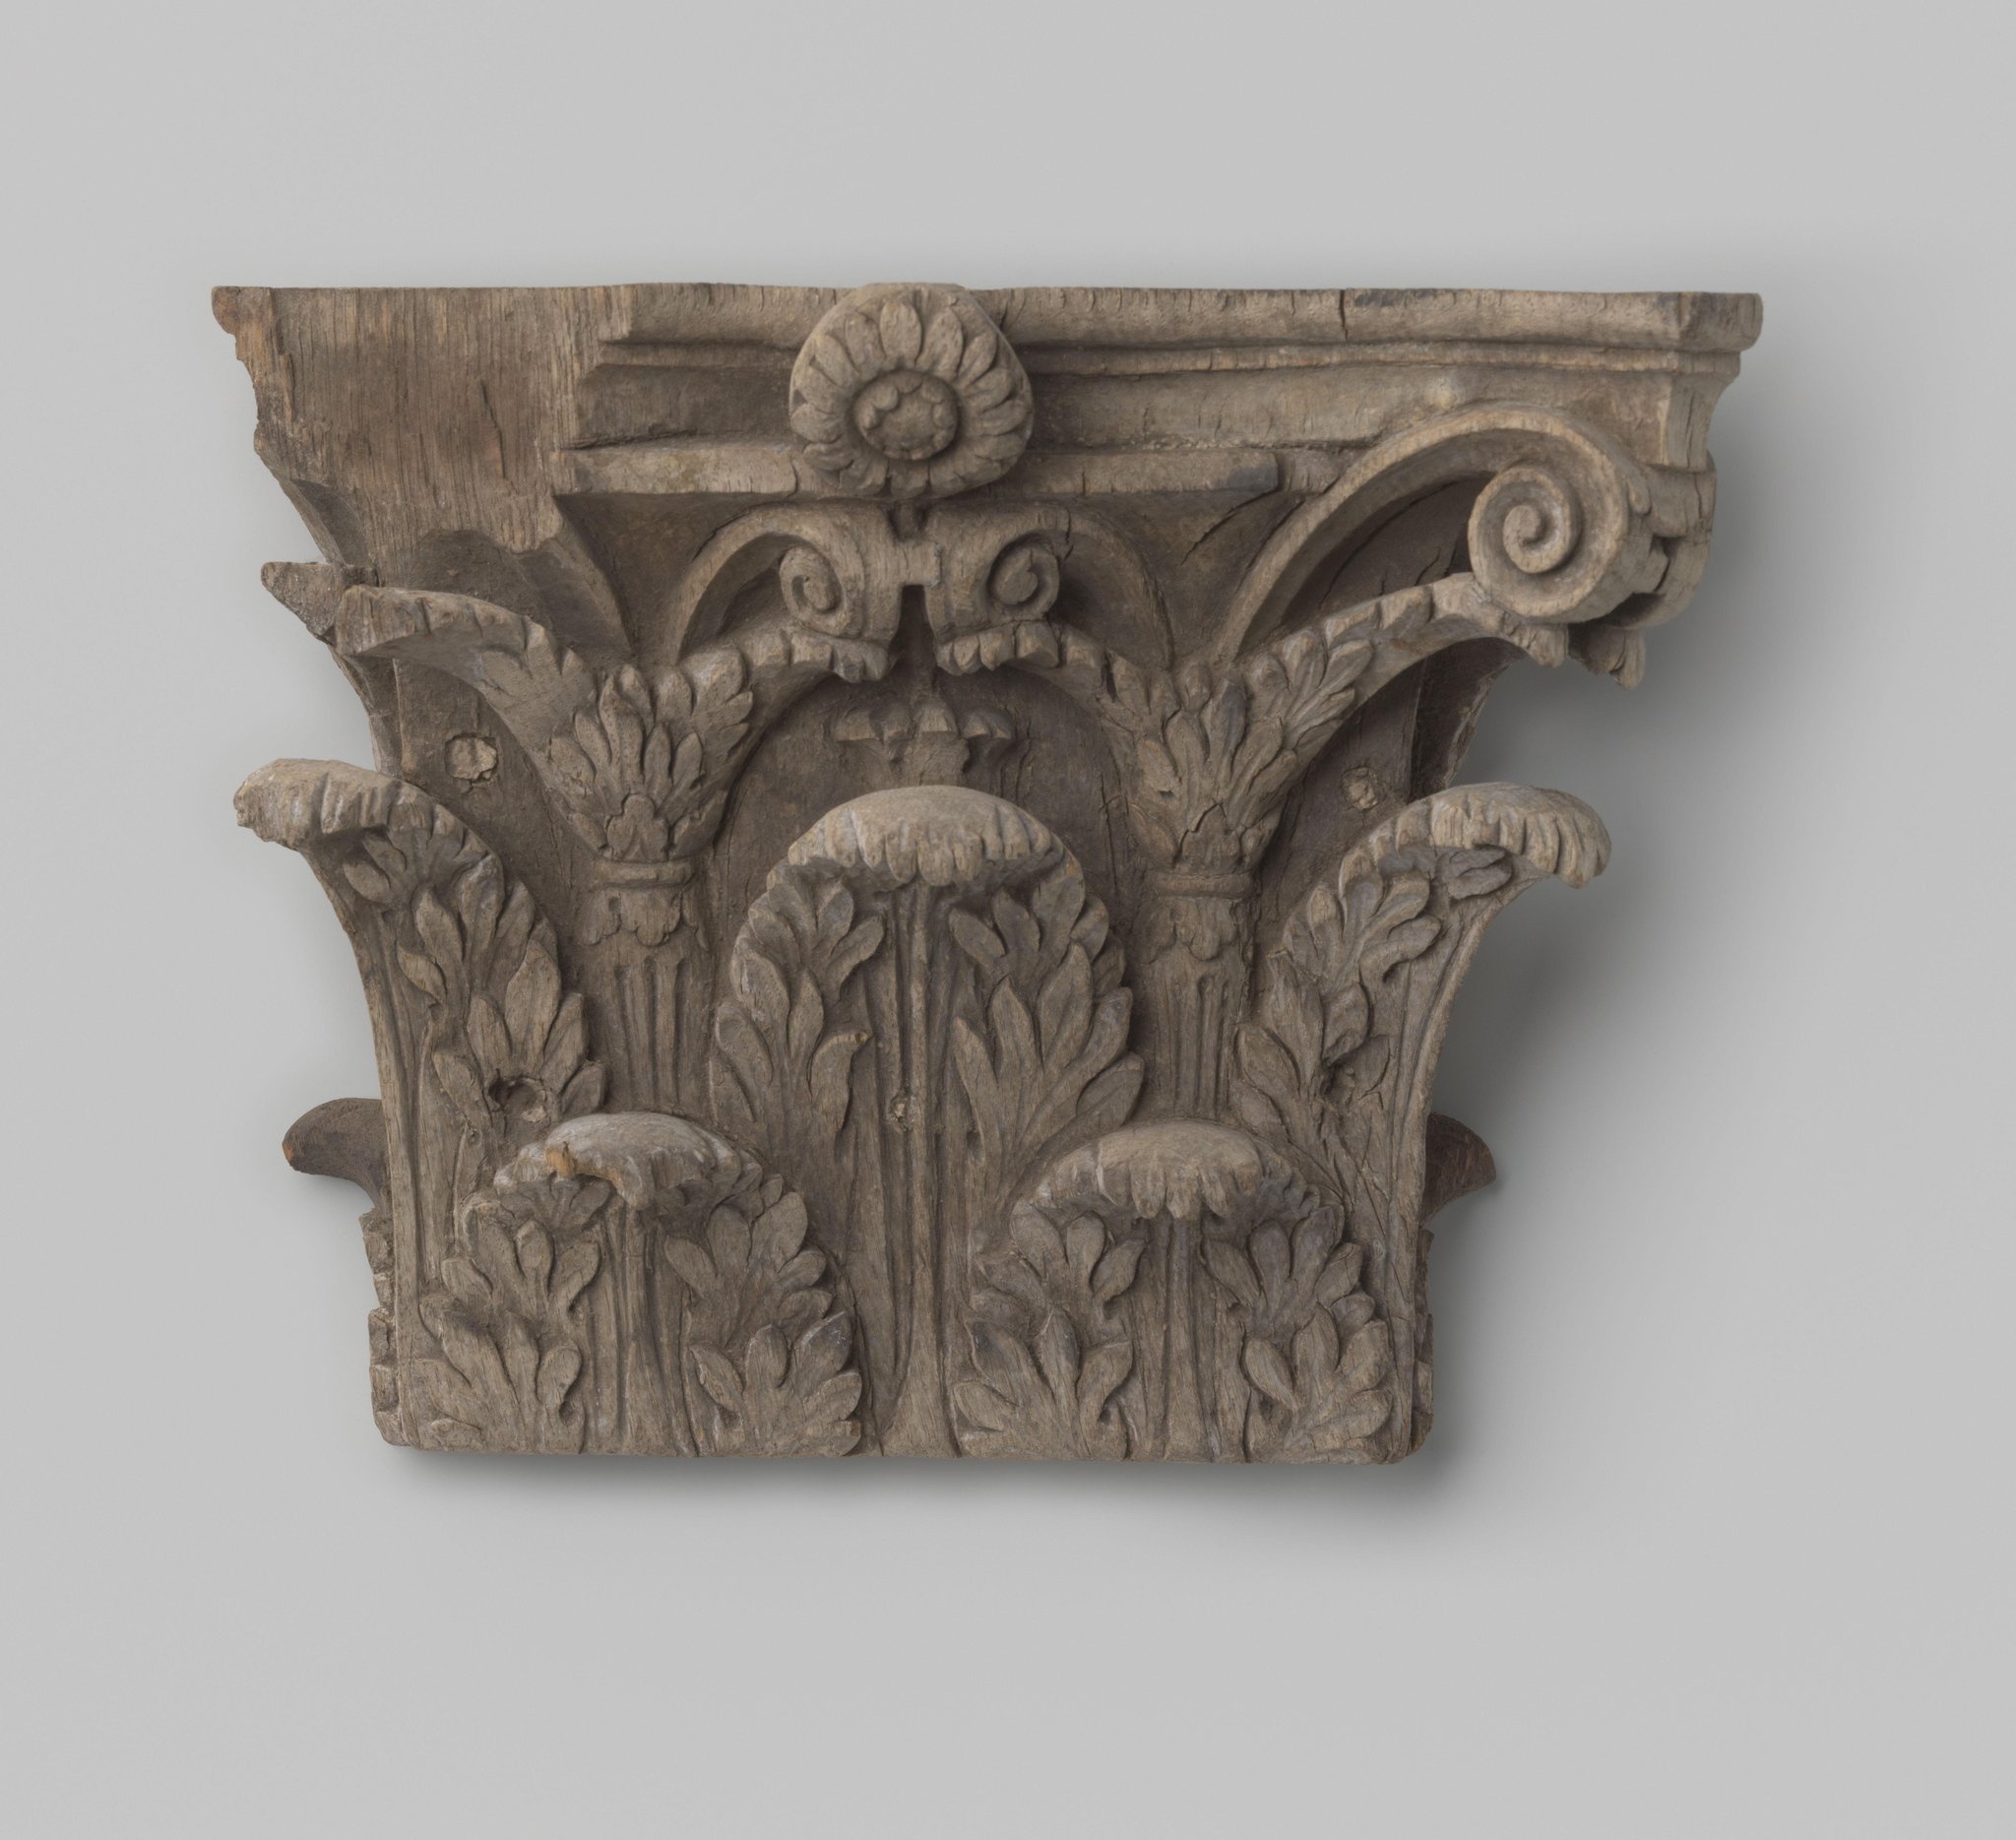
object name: capital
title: Bouwfragment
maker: Anonymous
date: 1700-1800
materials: wood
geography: netherlands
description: Eikenhouten Corintische pilasterkapiteel, waarvan één der voluten is afgebroken.